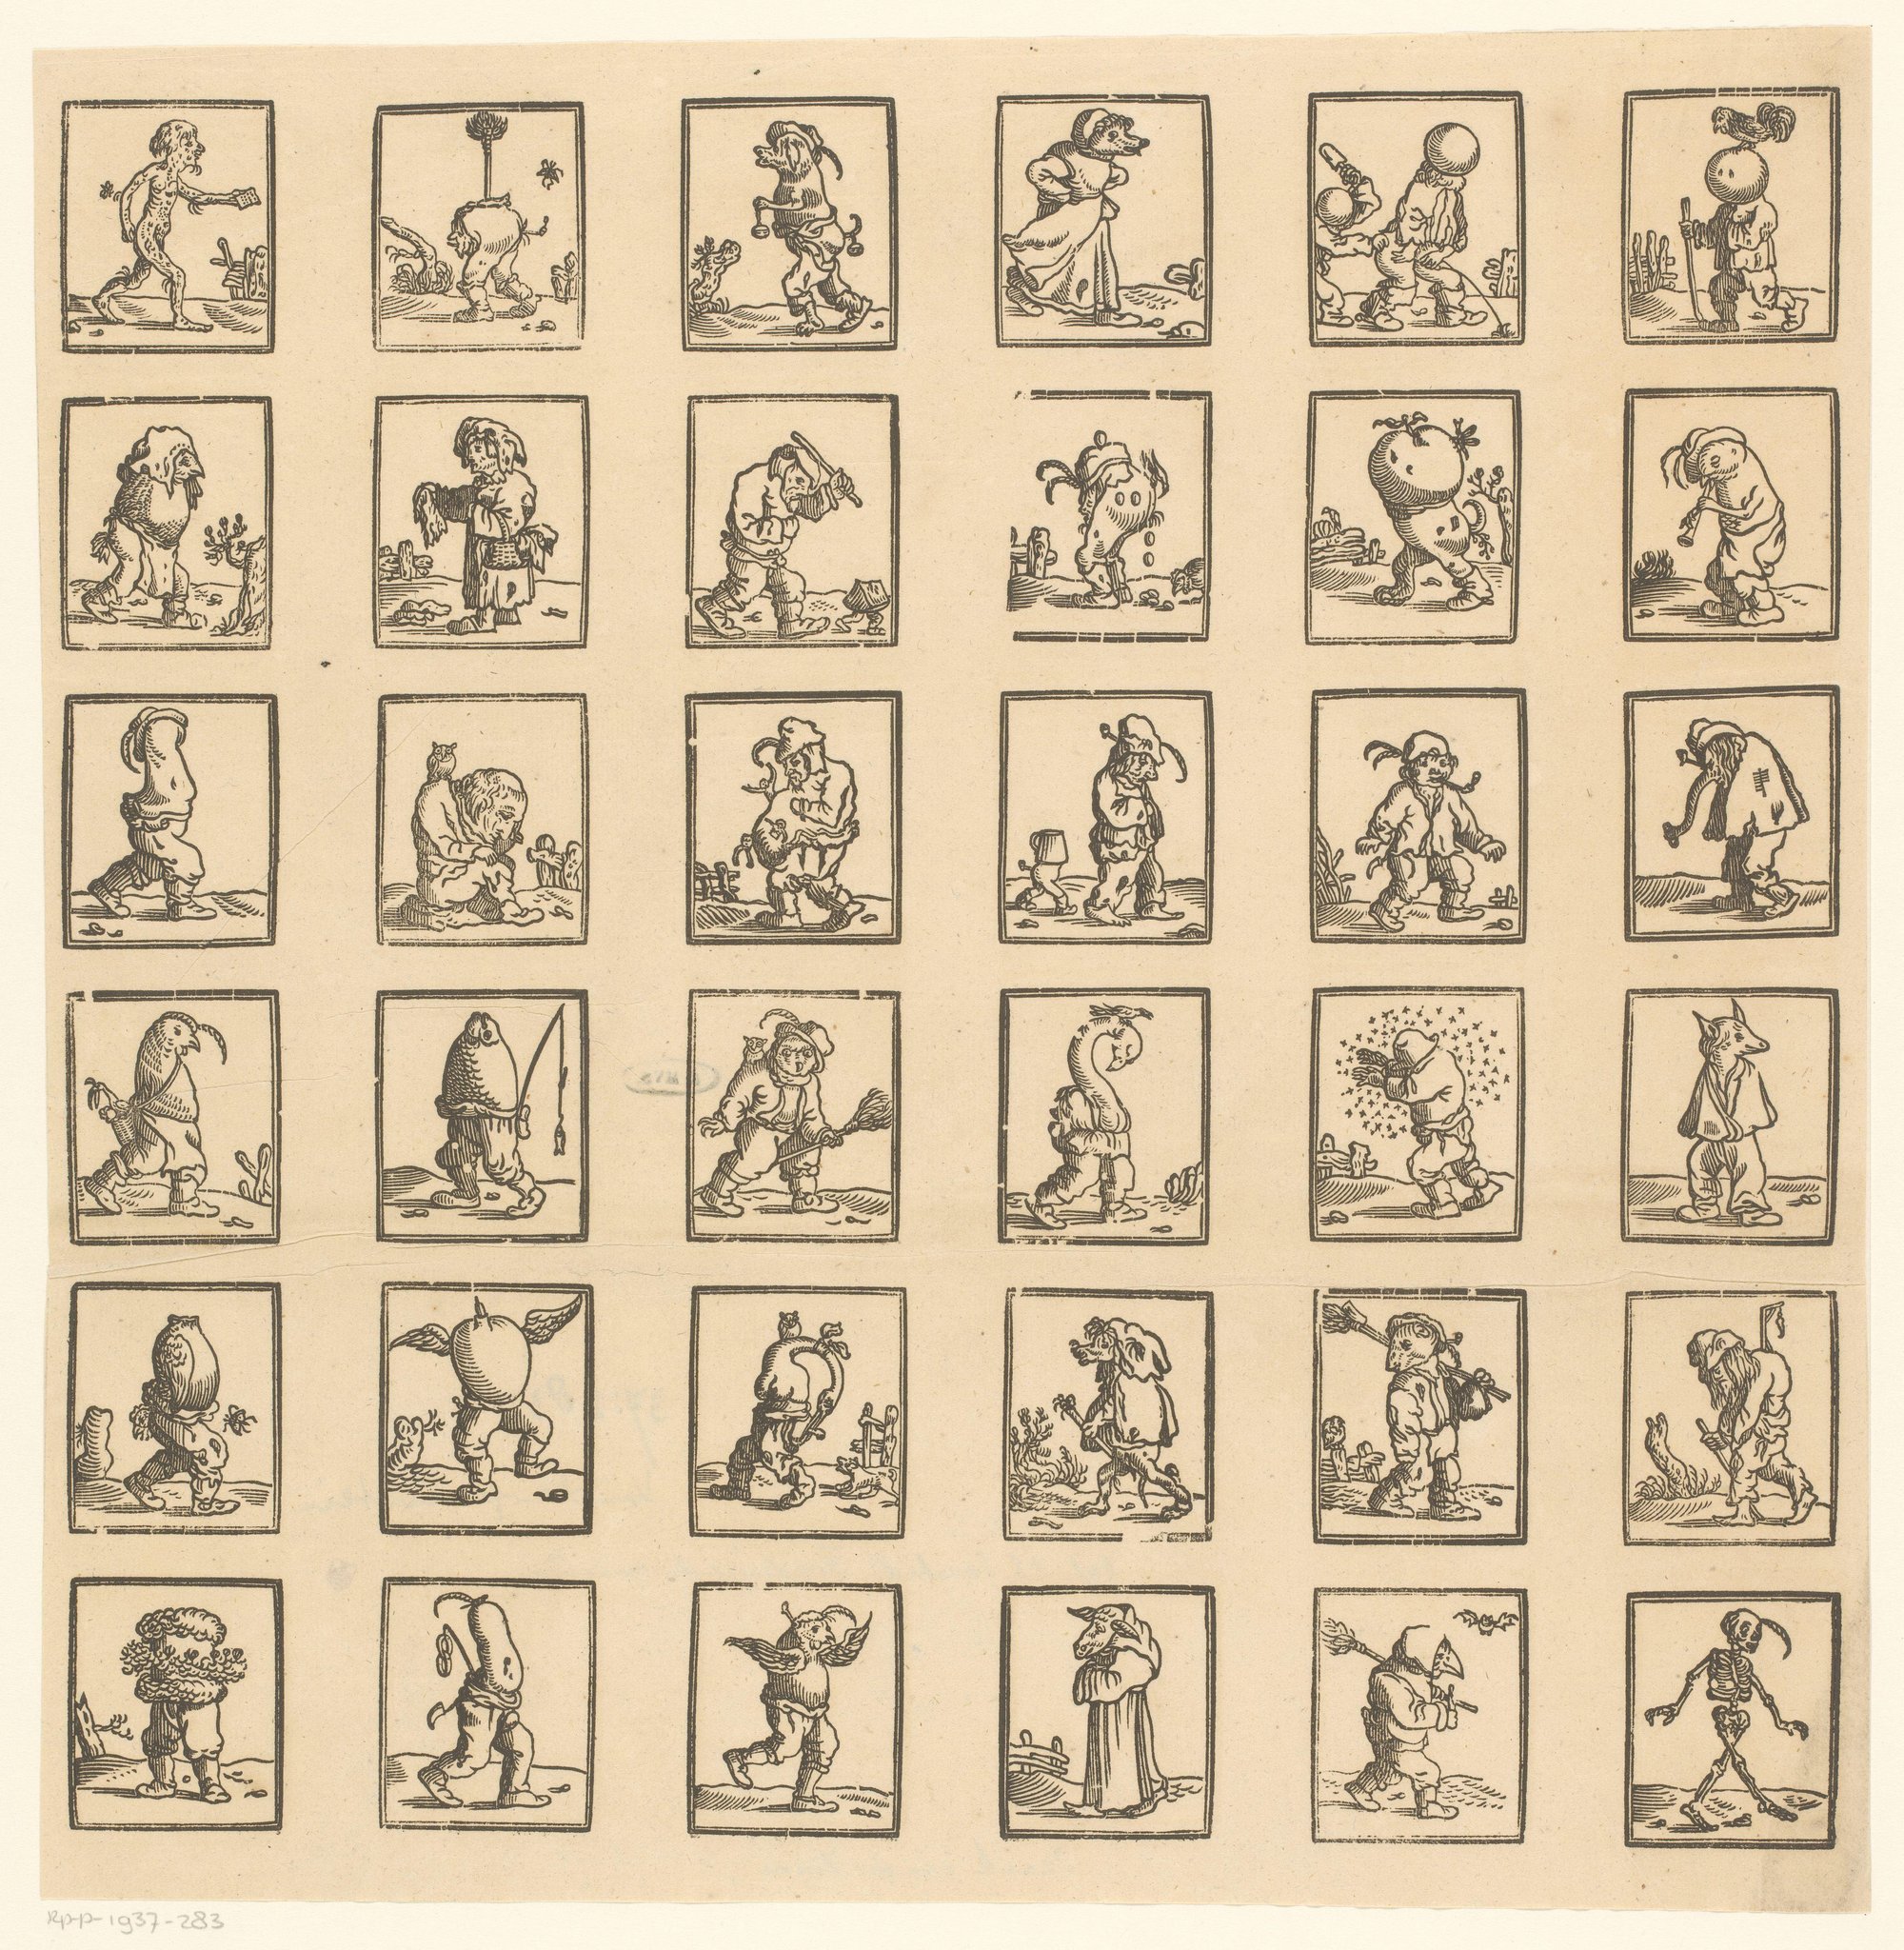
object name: popular print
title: Satirische voorstellingen van koddige figuren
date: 1730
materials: paper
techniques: woodcut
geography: netherlands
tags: caricatures (human types), monsters of mixed human and animal shape; 'mostri' (ripa)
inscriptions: collector's mark: Lugt 2228, collector's mark: Lugt 2760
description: Ook afdruk bekend met tekst in boekdruk, zie hiervoor RP-P-OB-30.881.